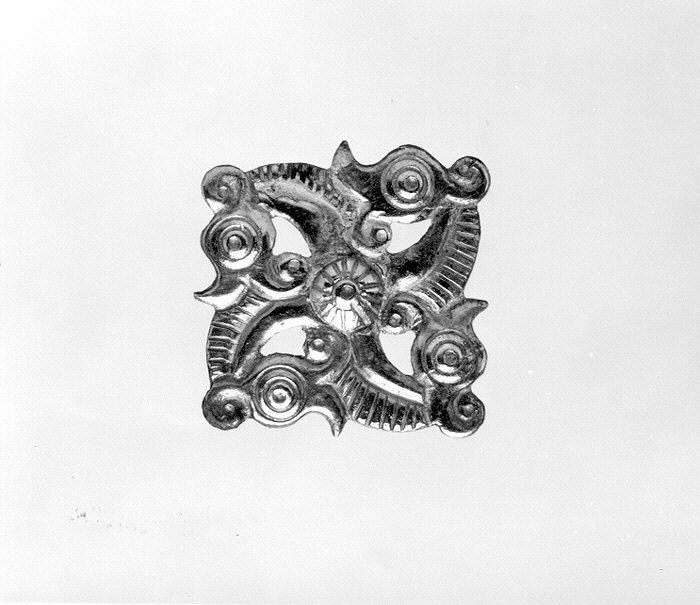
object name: appliqué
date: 500-301 BCE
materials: silver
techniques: gilding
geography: thrace